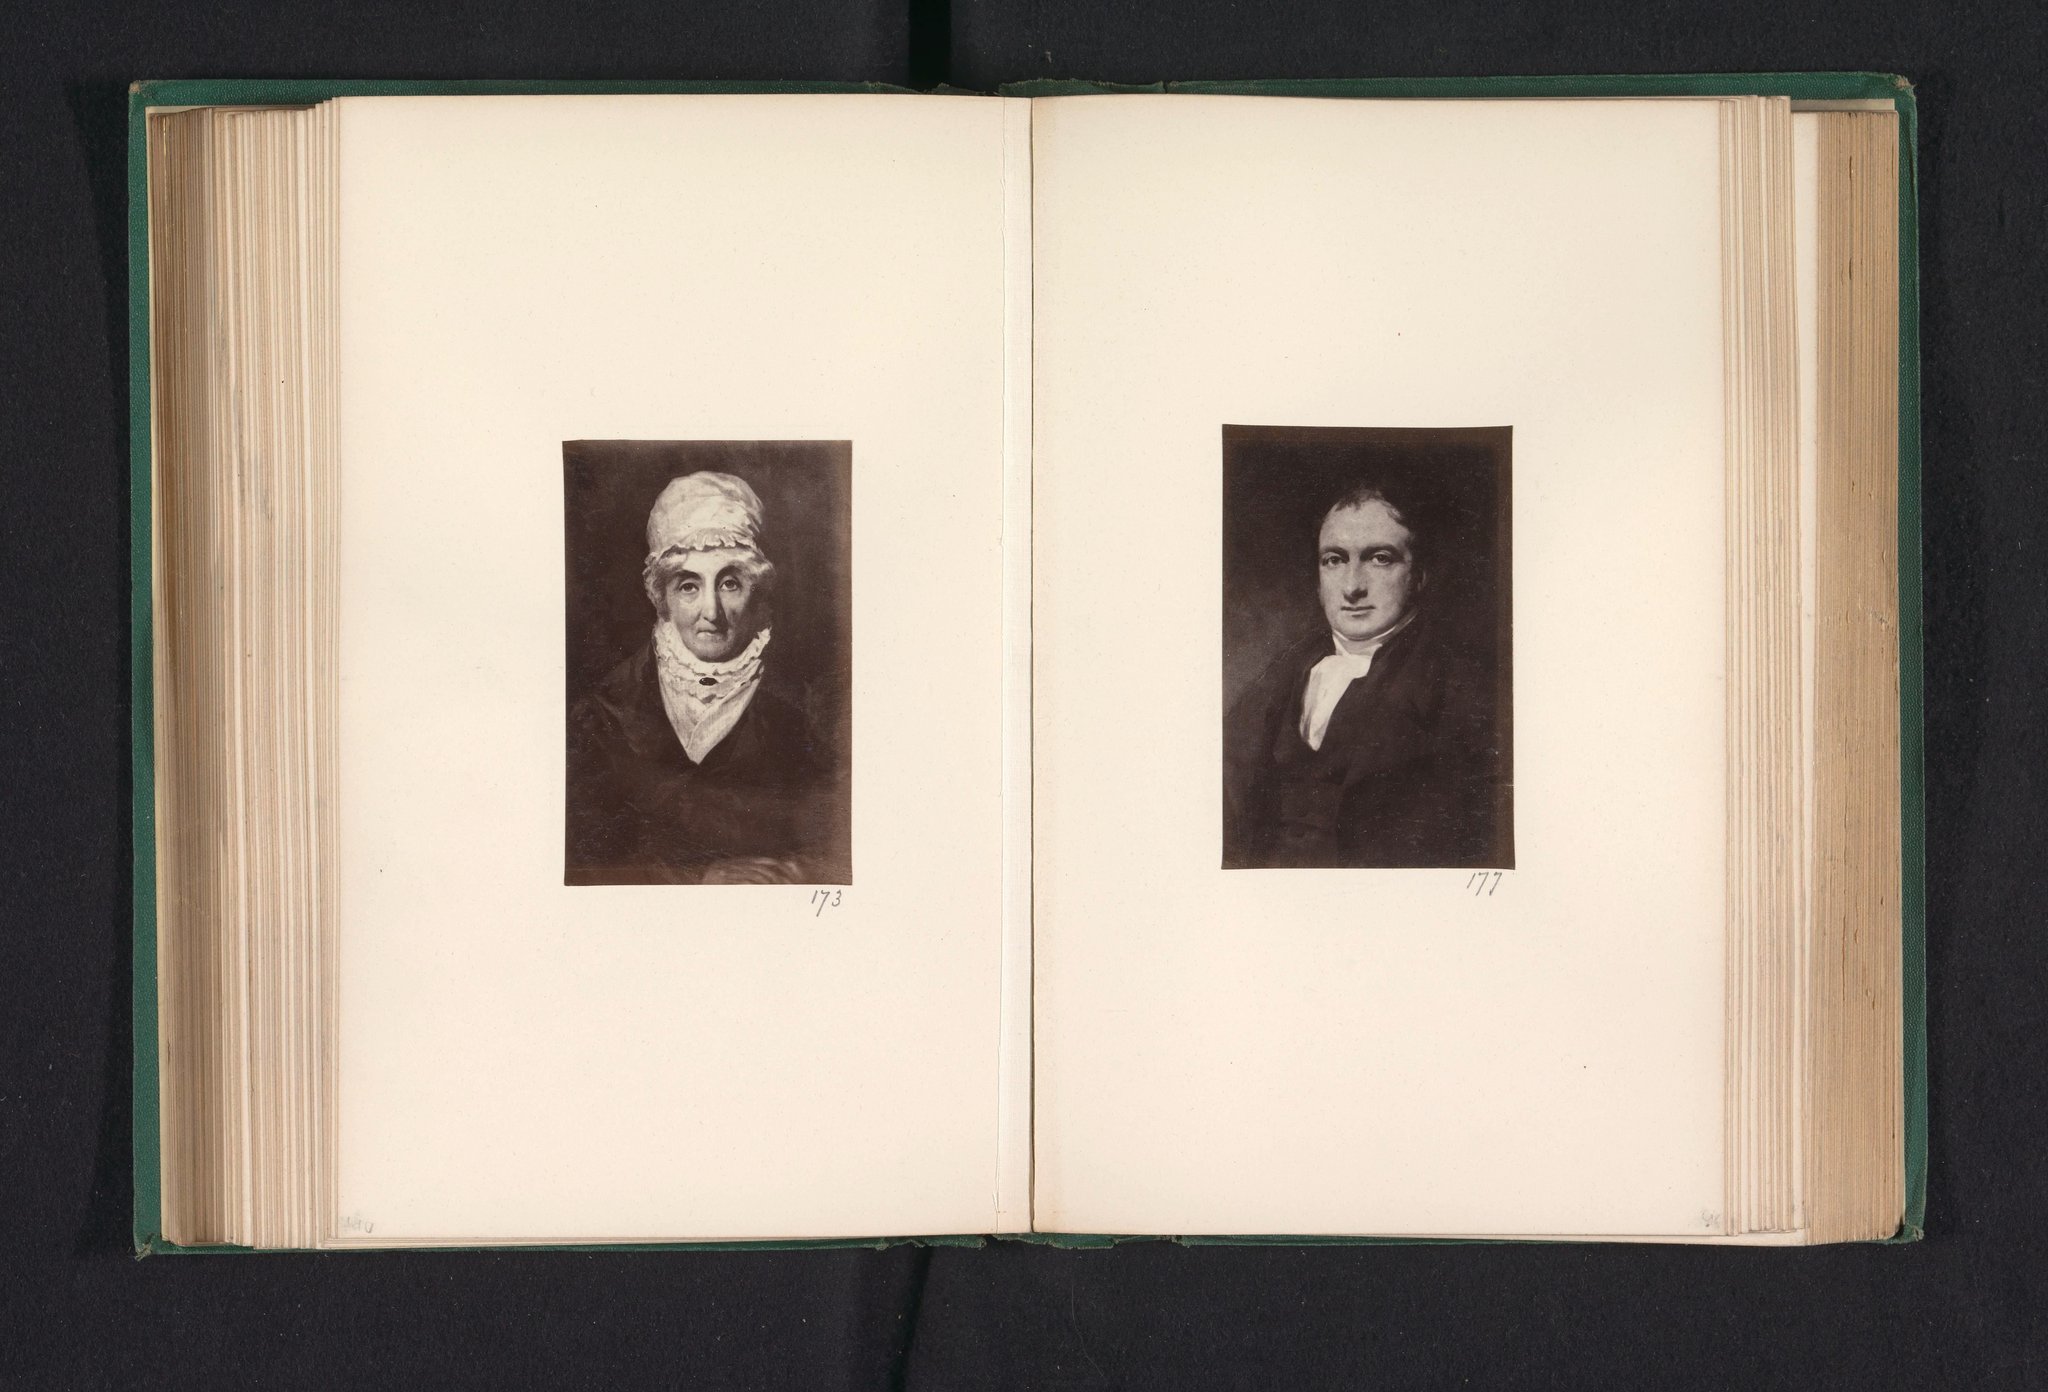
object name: reproduction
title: Fotoreproductie van een schilderij, voorstellende een portret van Mungo Nutter Campbell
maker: thomas annan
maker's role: fotograaf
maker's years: 1829-1887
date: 1863-1868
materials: photographic support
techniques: albumen print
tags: historical persons (portraits and scenes from the life) (+ (full) bust portrait)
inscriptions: number: ‘177’